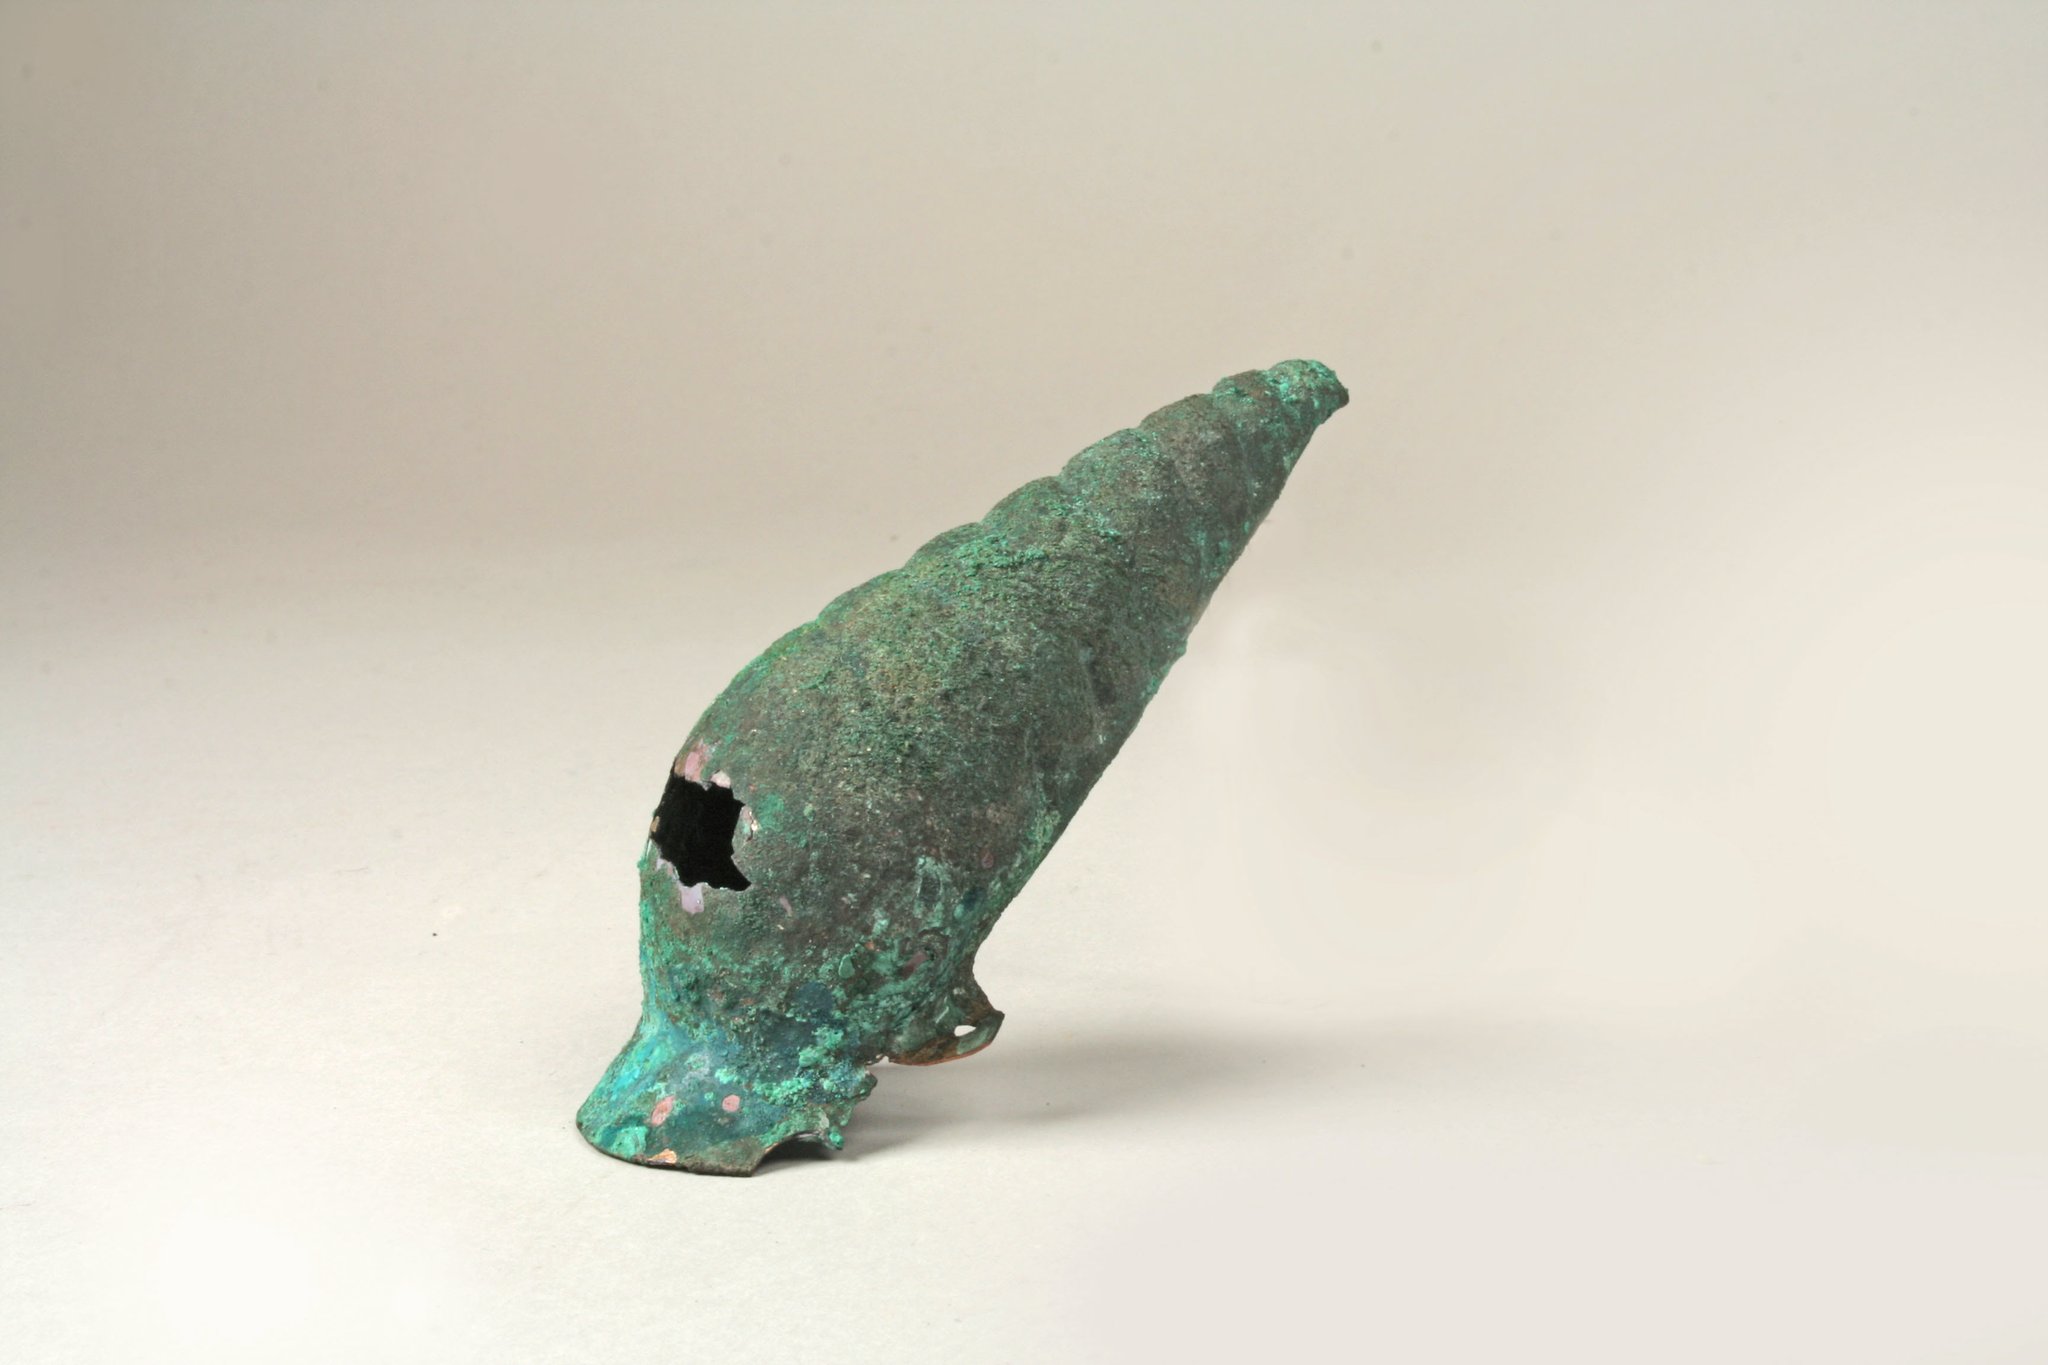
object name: ornament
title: Shell Ornaments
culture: moche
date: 501-700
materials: gilt copper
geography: peru